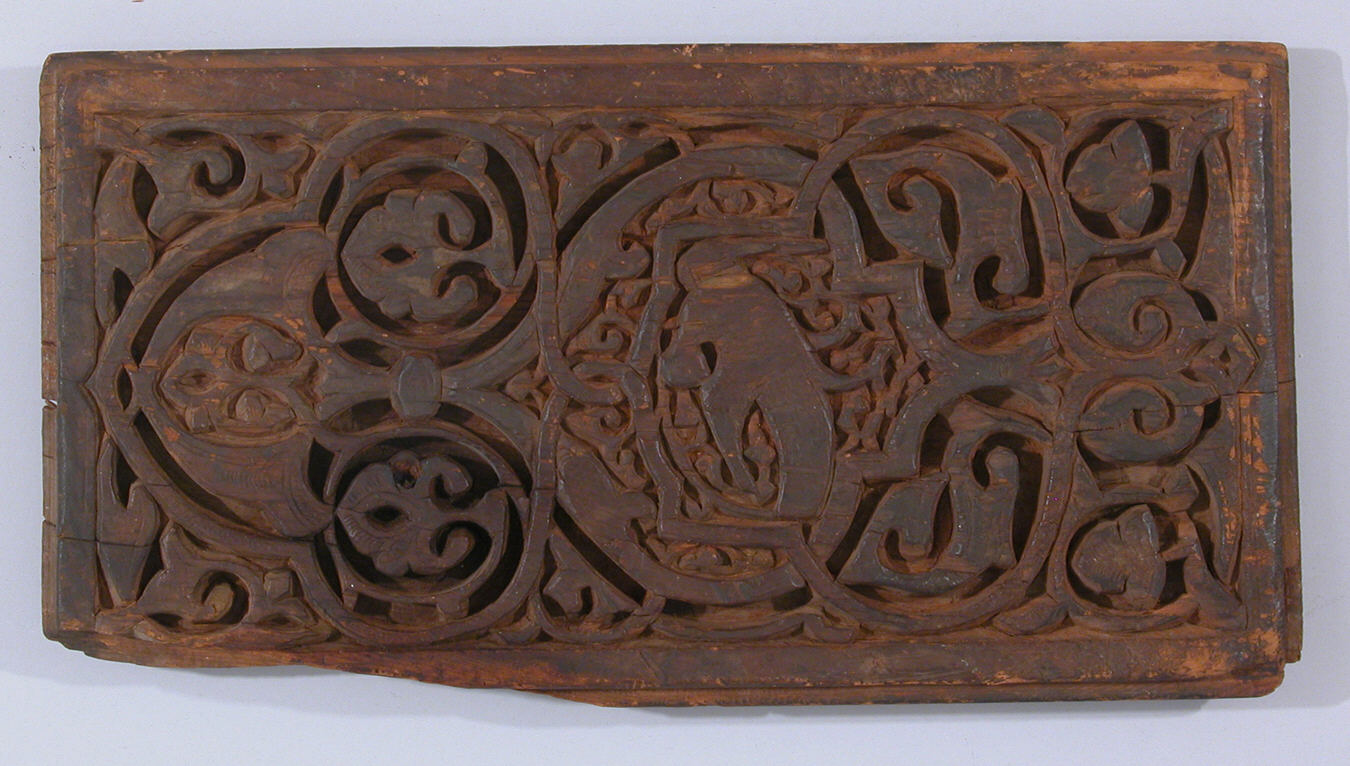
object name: panel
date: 1101-1200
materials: wood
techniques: carving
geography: egypt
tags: architecture